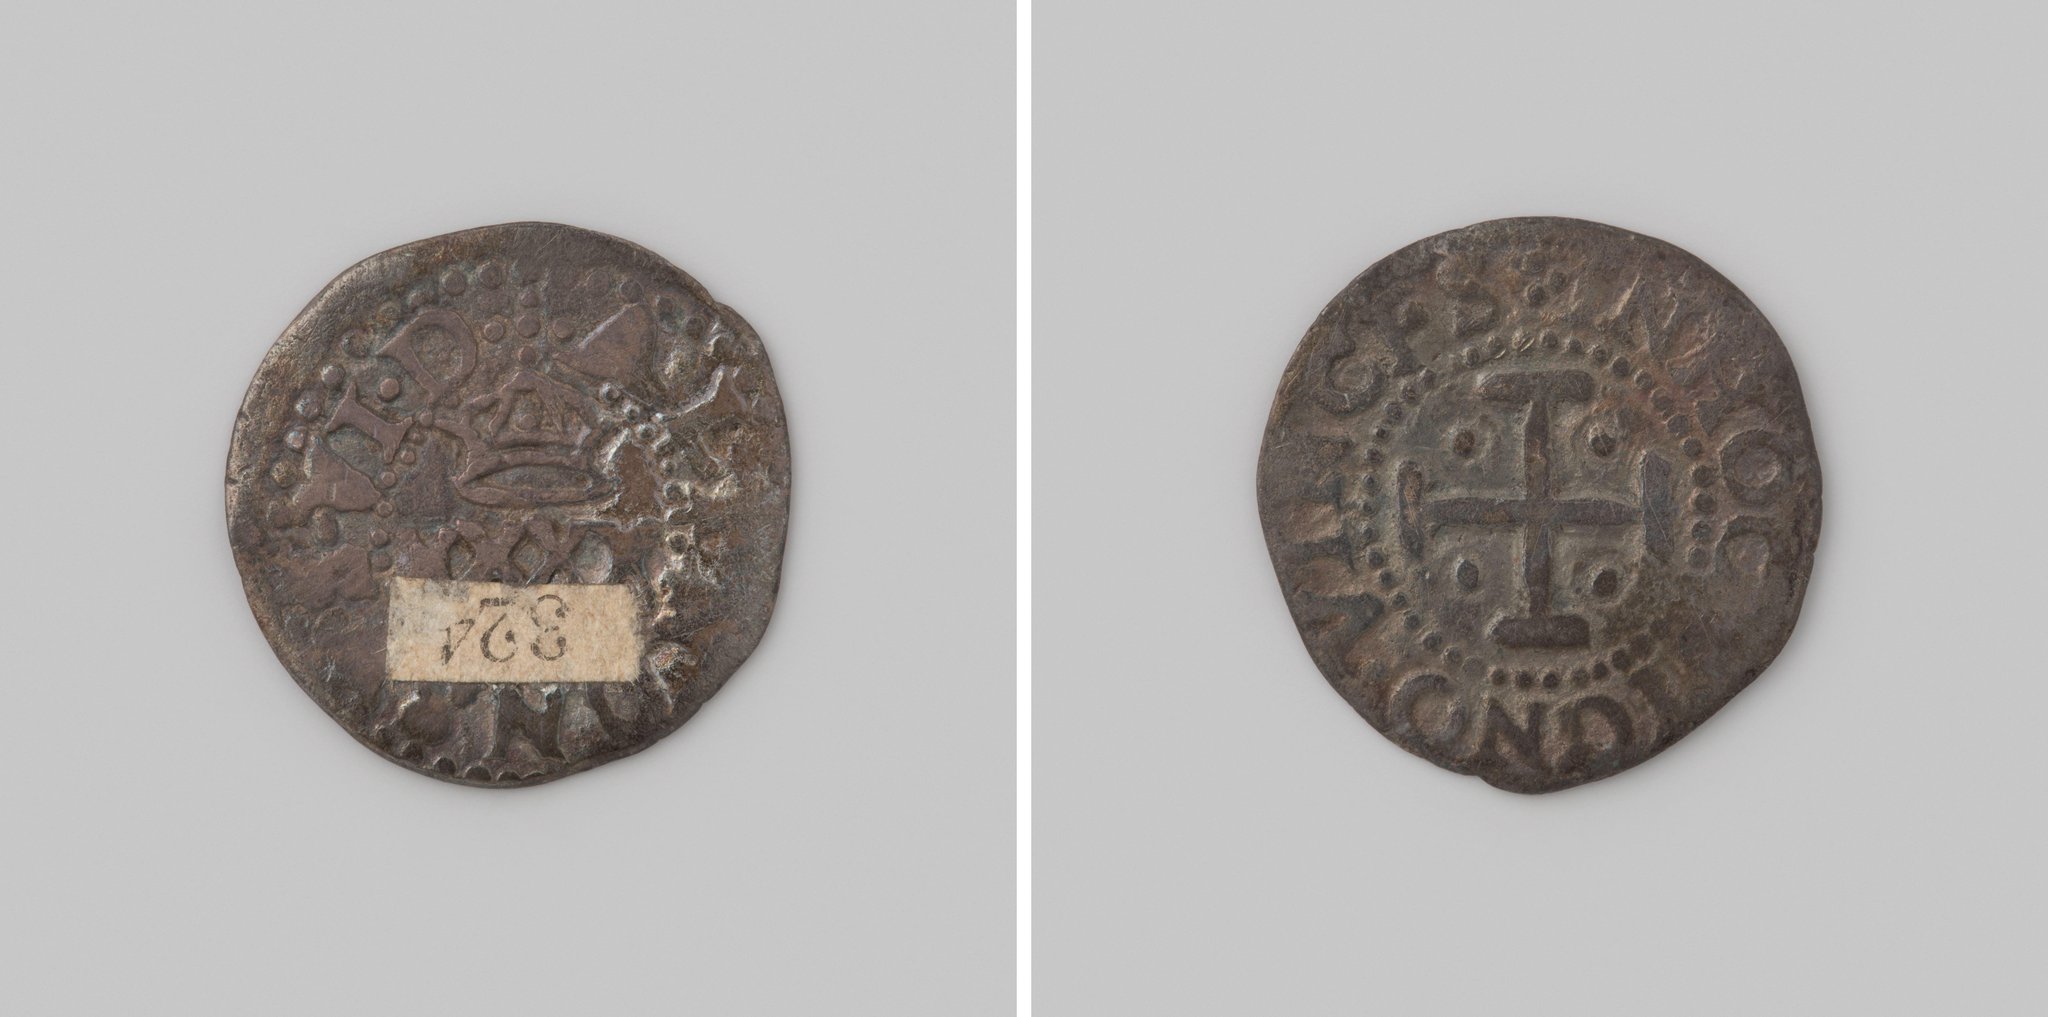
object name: coin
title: Portugal, koning Alfonso VI, 1656-1683, twee vintems of 40 reis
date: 1656-1683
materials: silver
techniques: striking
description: Zilveren munt. Voorzijde: kroon, waaronder waarde-aanduiding: XXXX. Omschrift eindigend in: D. Keerzijde: kort gevoet kruis, met in de hoeken stippen.